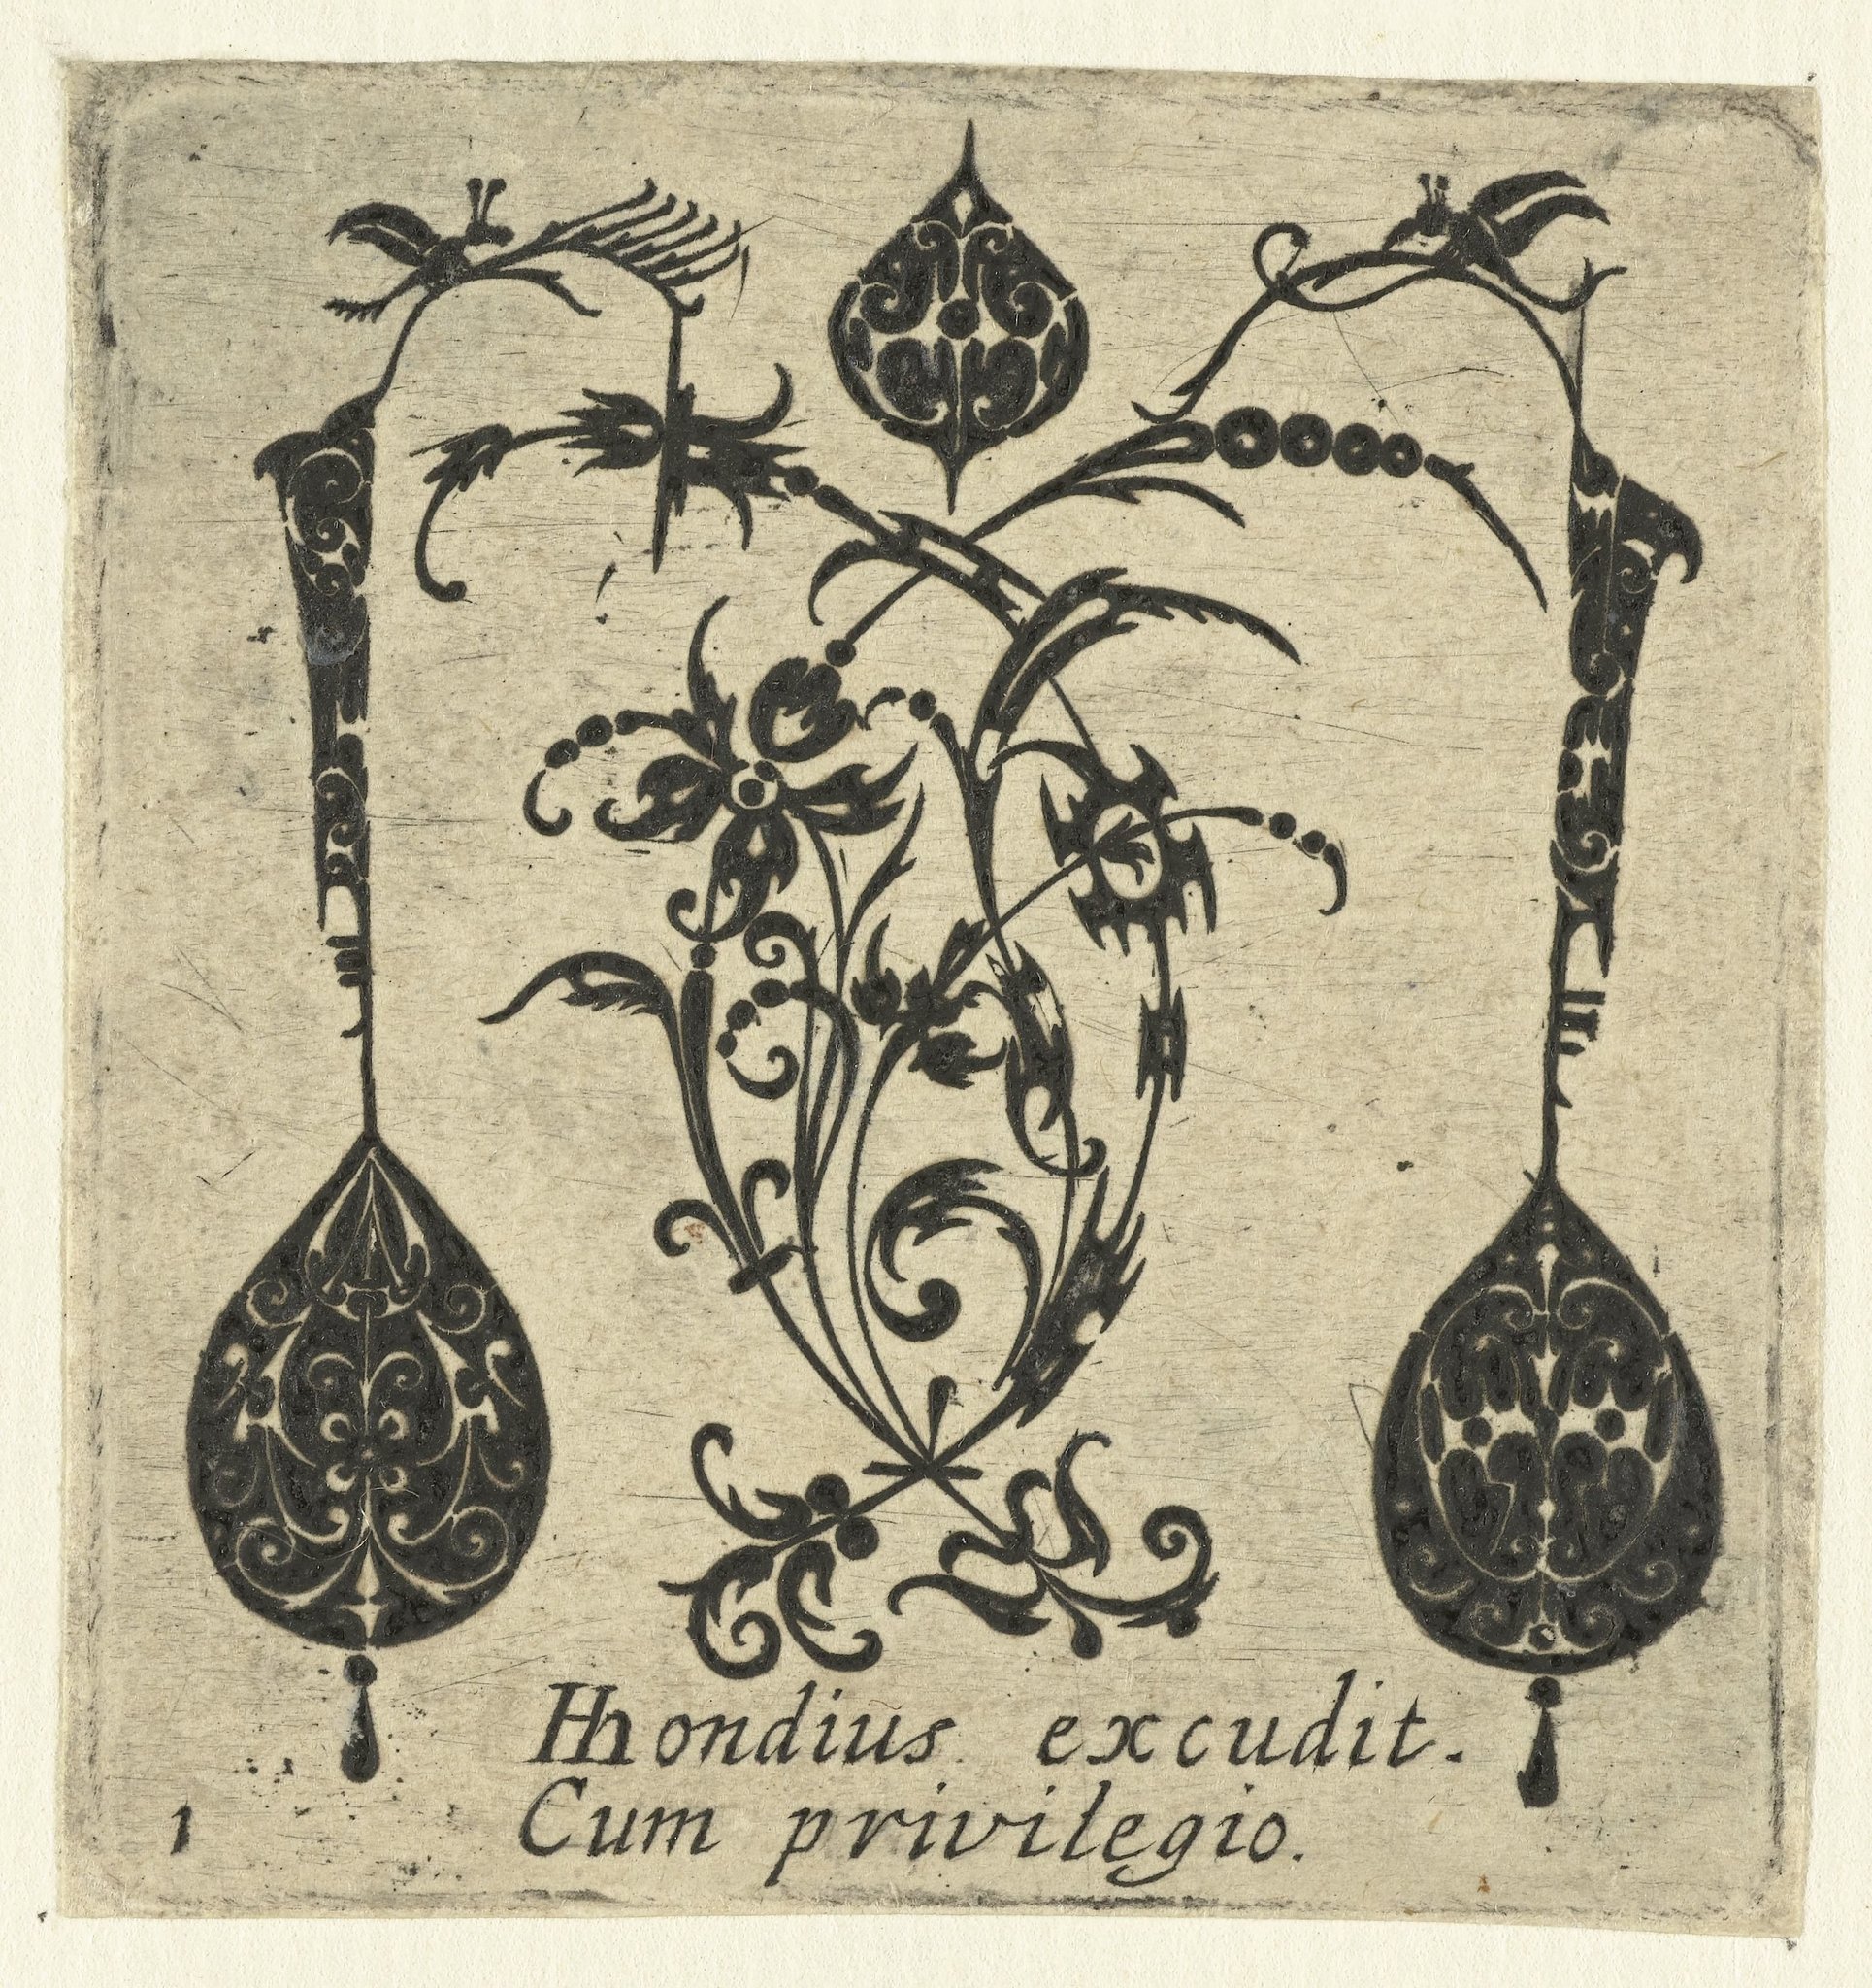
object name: ornament print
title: Ontwerpen voor sieraden in de vorm van zwartornamenten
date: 1612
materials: paper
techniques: engraving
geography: leiden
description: In het midden twee gestileerde ranken met rolwerk, midden boven een traanvormig ornament en aan beide zijkanten een ornament opgedeeld in twee helften en een oorring.